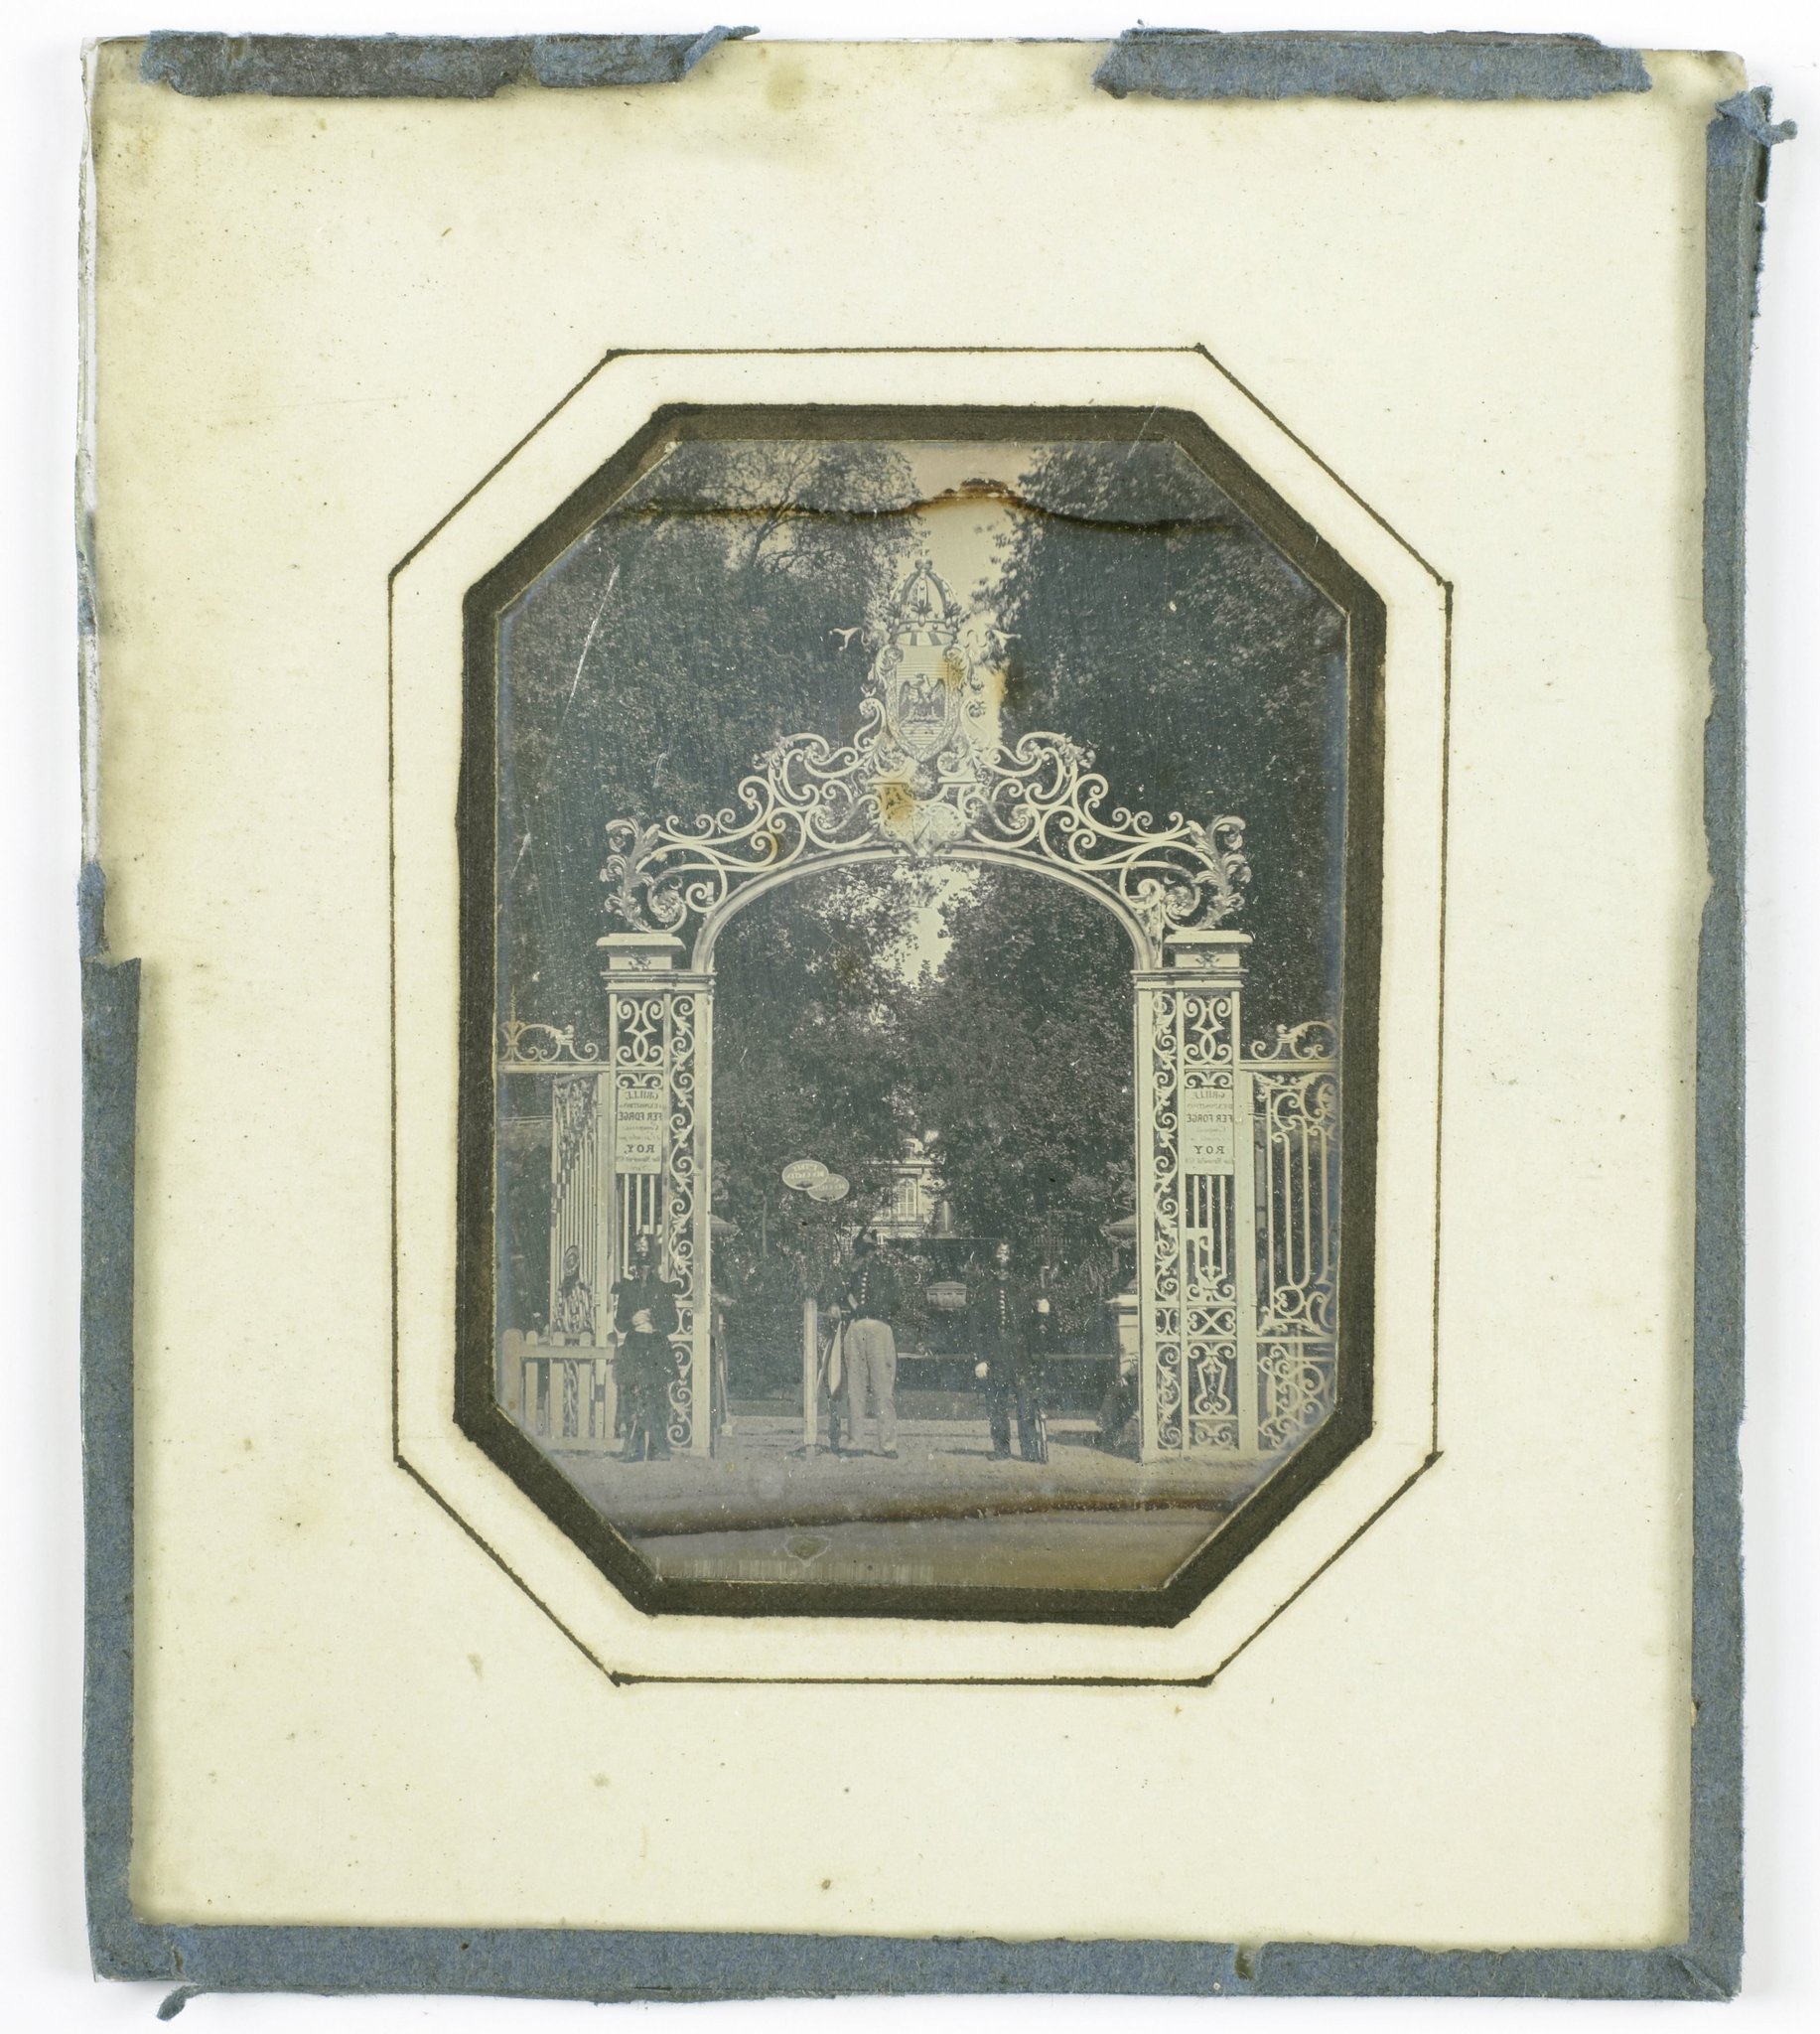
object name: photograph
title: Poort op de Wereldtentoonstelling in Parijs 1855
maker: hermann krone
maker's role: fotograaf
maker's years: 1827-1916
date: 1855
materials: copper, glass, paper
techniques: daguerreotype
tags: trees, historical persons, gate, entrance, paris